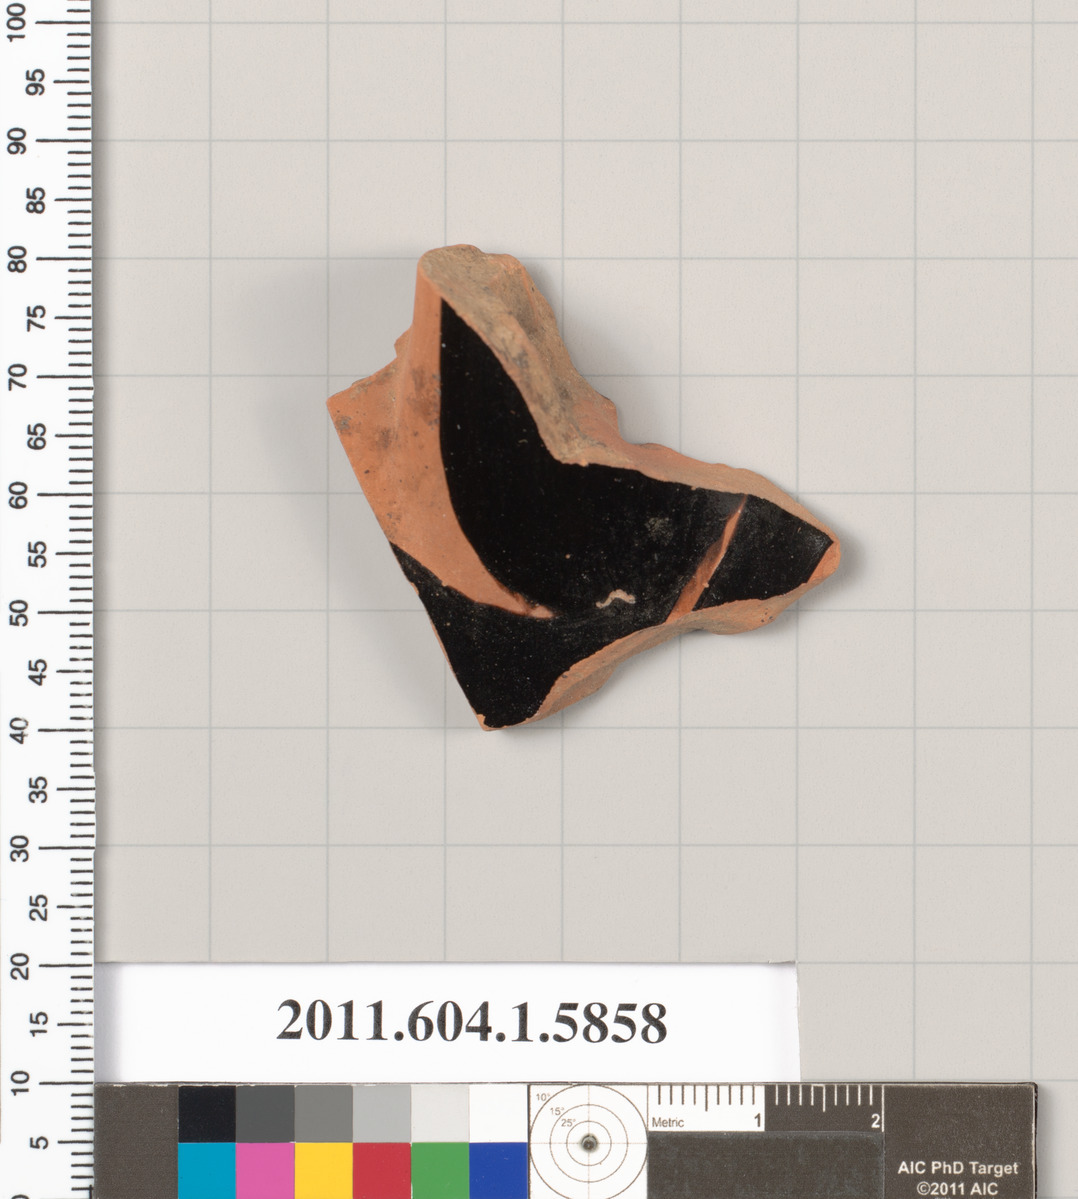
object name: kylix fragment, eye cup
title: Terracotta fragment of a kylix: eye-cup (drinking cup)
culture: greek, attic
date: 433-567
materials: terracotta